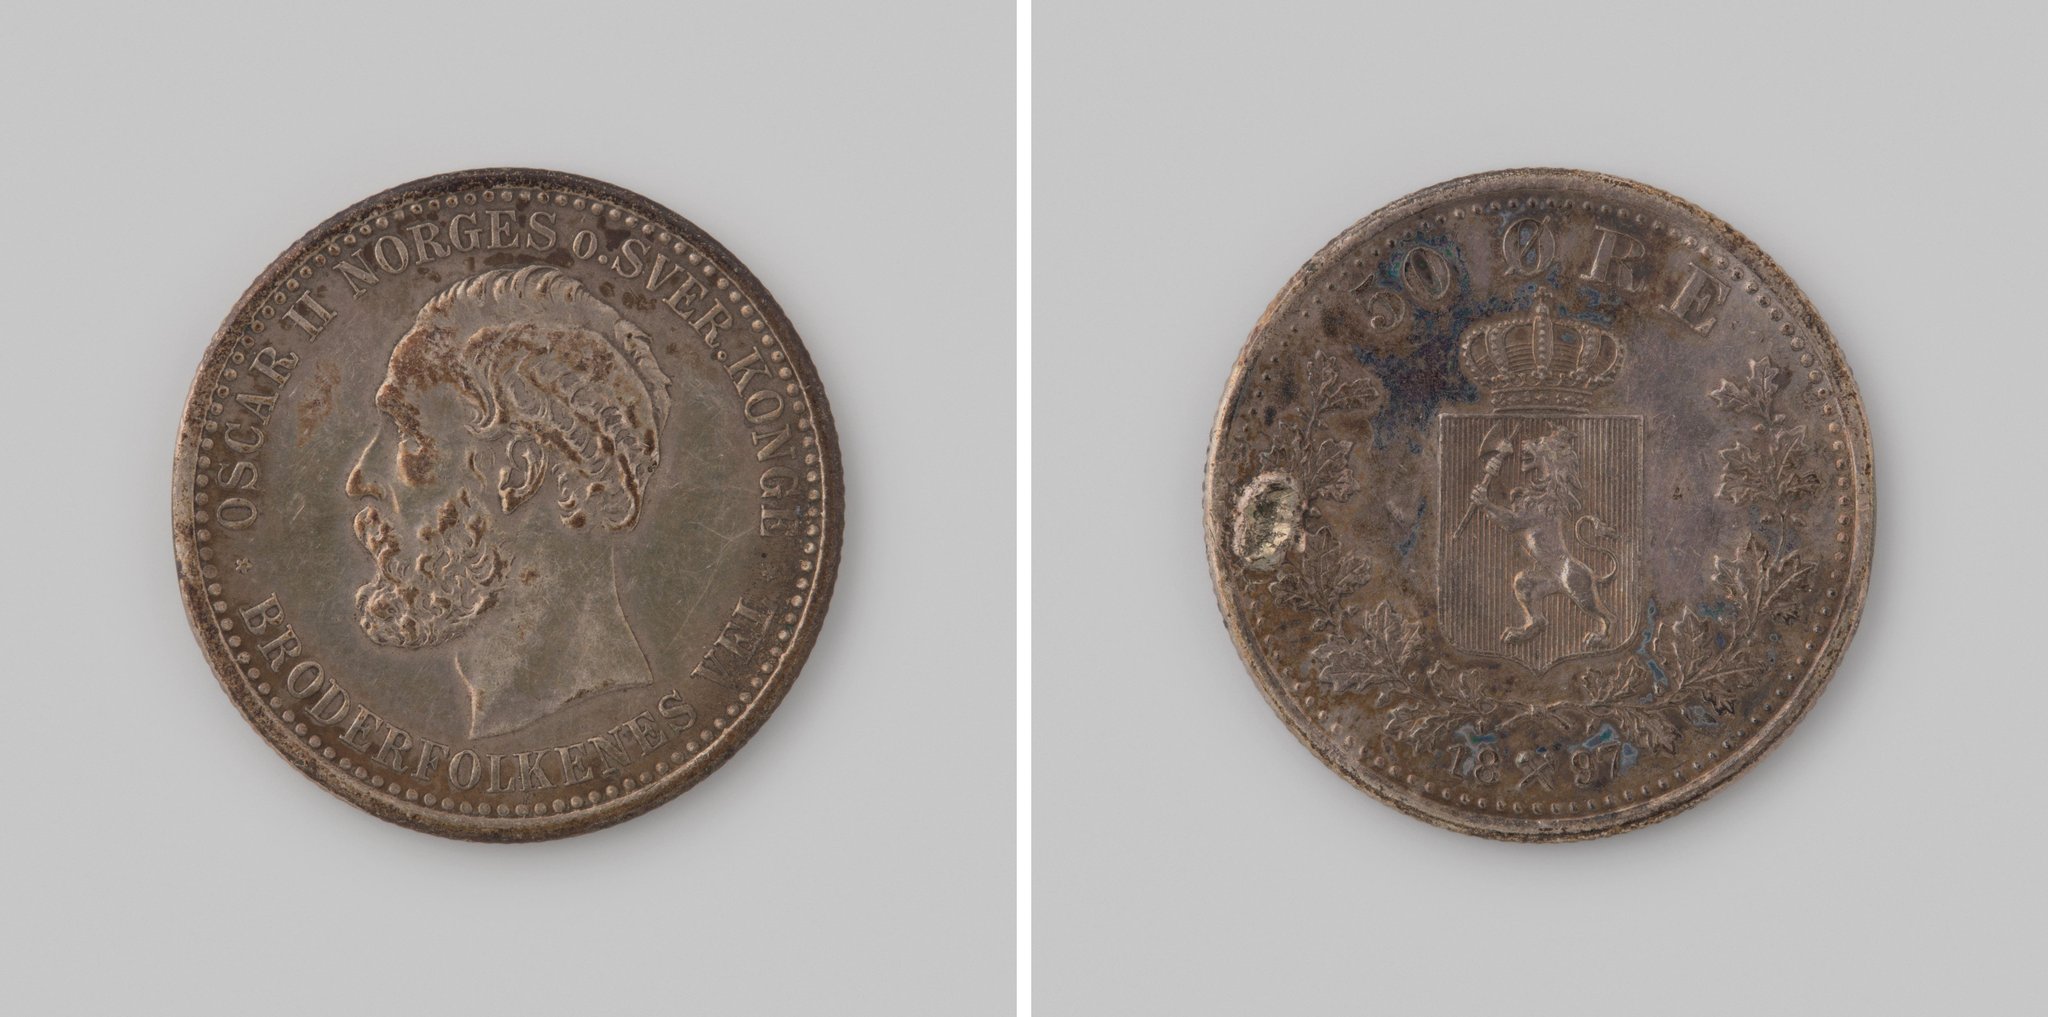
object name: coin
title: Noorwegen, Oskar II, 50 öre, 1897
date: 1897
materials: silver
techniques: striking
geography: kongsberg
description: Zilveren munt. Voorzijde: hoofd monogram van de koning naar links. Keerzijde: binnen twee samengebonden eiketakken gekroond wapenschild, waarboven waarde-aanduiding als omschrift. Onderaan jaartal, waartussen aanduiding van de muntplaats. Kartelrand. Beschadiging [soldeersel] op keerzijde.